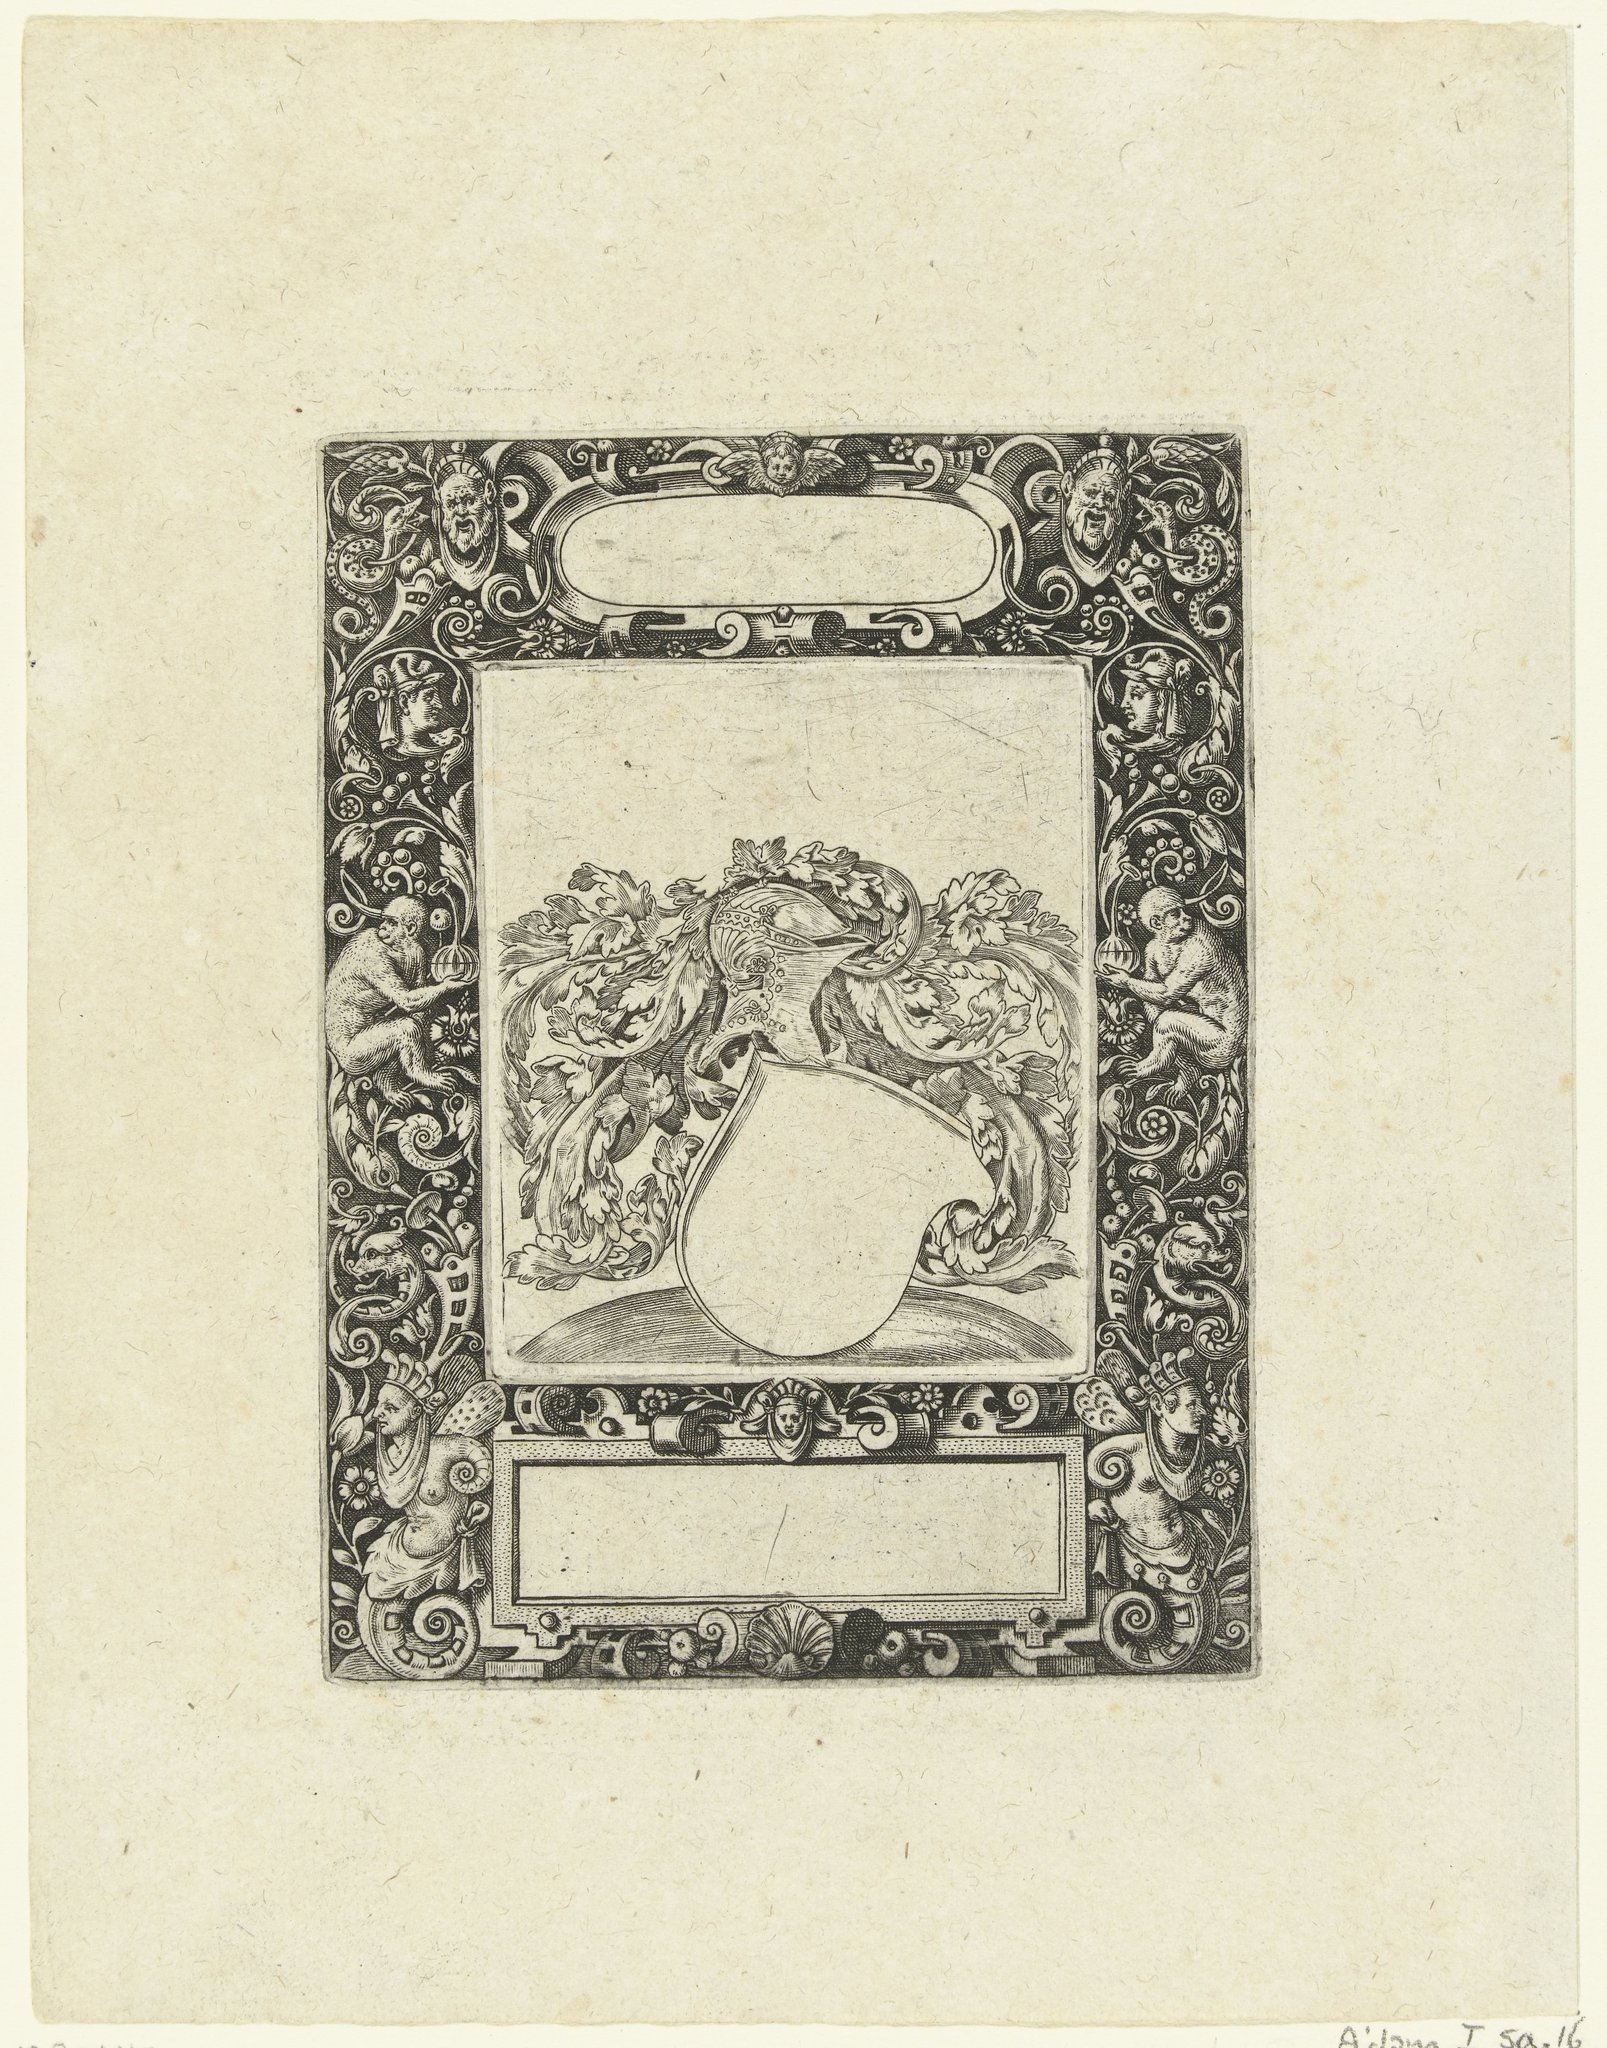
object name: ornament print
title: Emblemata Nobilitati et Vulgo scitu digna…/ Stam und Wapenbuchlein…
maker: theodor de bry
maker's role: draughtsman, print maker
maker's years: 1528-1598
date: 1593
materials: paper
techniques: engraving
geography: netherlands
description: Middenonder een rechthoekige cartouche. Links en rechts in het midden zit een aap. Links- en rechtsonder rust op een voluut het bovenlichaam van een gevleugelde vrouw met een tooi op haar hoofd. Hoort bij een serie van 18 bladen waarbij in het midden van aparte platen zevenentwintig emblemata en vijfenveertig wapenschilden zijn gedrukt. De emblemata zijn ten dele genummerd A-D, 1-7 en 9-21. Drie bladen hebben geen nummer. De wapenschilden, die deels dubbel zijn afgedrukt, zijn ongenummerd.